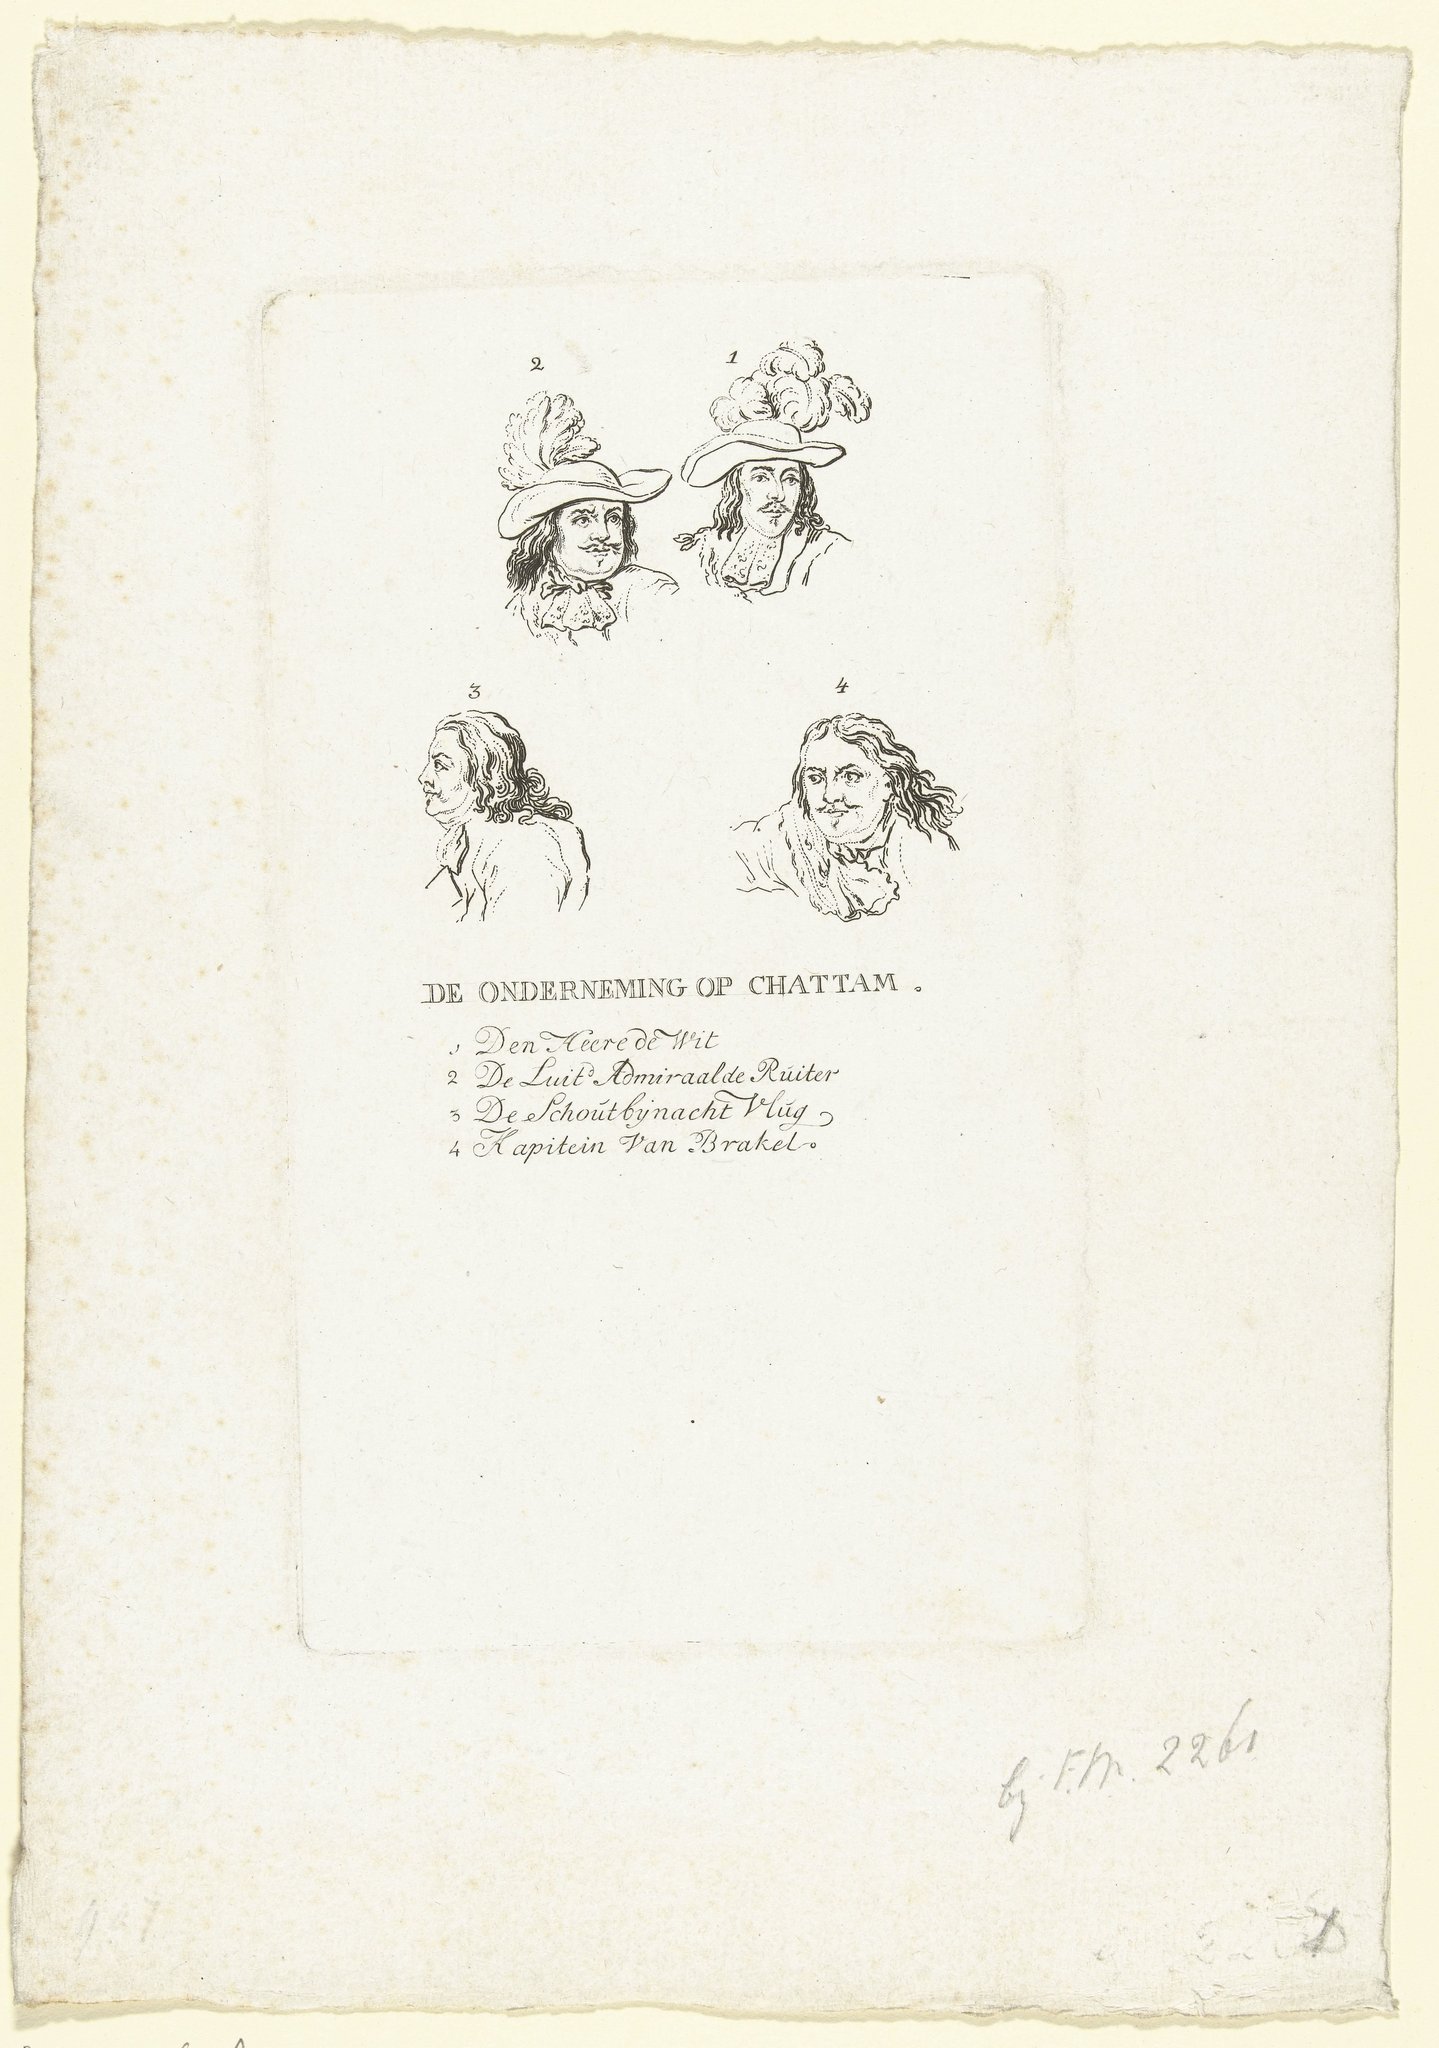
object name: history print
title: De onderneming op Chattam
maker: mathias de sallieth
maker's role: print maker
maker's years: 1749-1791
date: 1782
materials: paper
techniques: etching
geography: northern netherlands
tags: flushing, michiel adriaenszoon de ruyter, dordrecht, cornelis de witt, historical persons, commander-in-chief, admiral, raid on the medway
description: De hoofden van de vier hoofdpersonen op de voorstelling van de gevechten te Chatham en de verovering van het Engelse vlaggeschip de Royal Charles op 22 juni 1667. De hoofden genummerd 1: Cornelis de Witt, 2: Michiel Adriaenszoon de Ruyter, 3: schout-bij-nacht David Vlugh, 4: kapitein Jan van Brakel. Deze sleutel behoort bij de grote voorstelling van het gevecht.